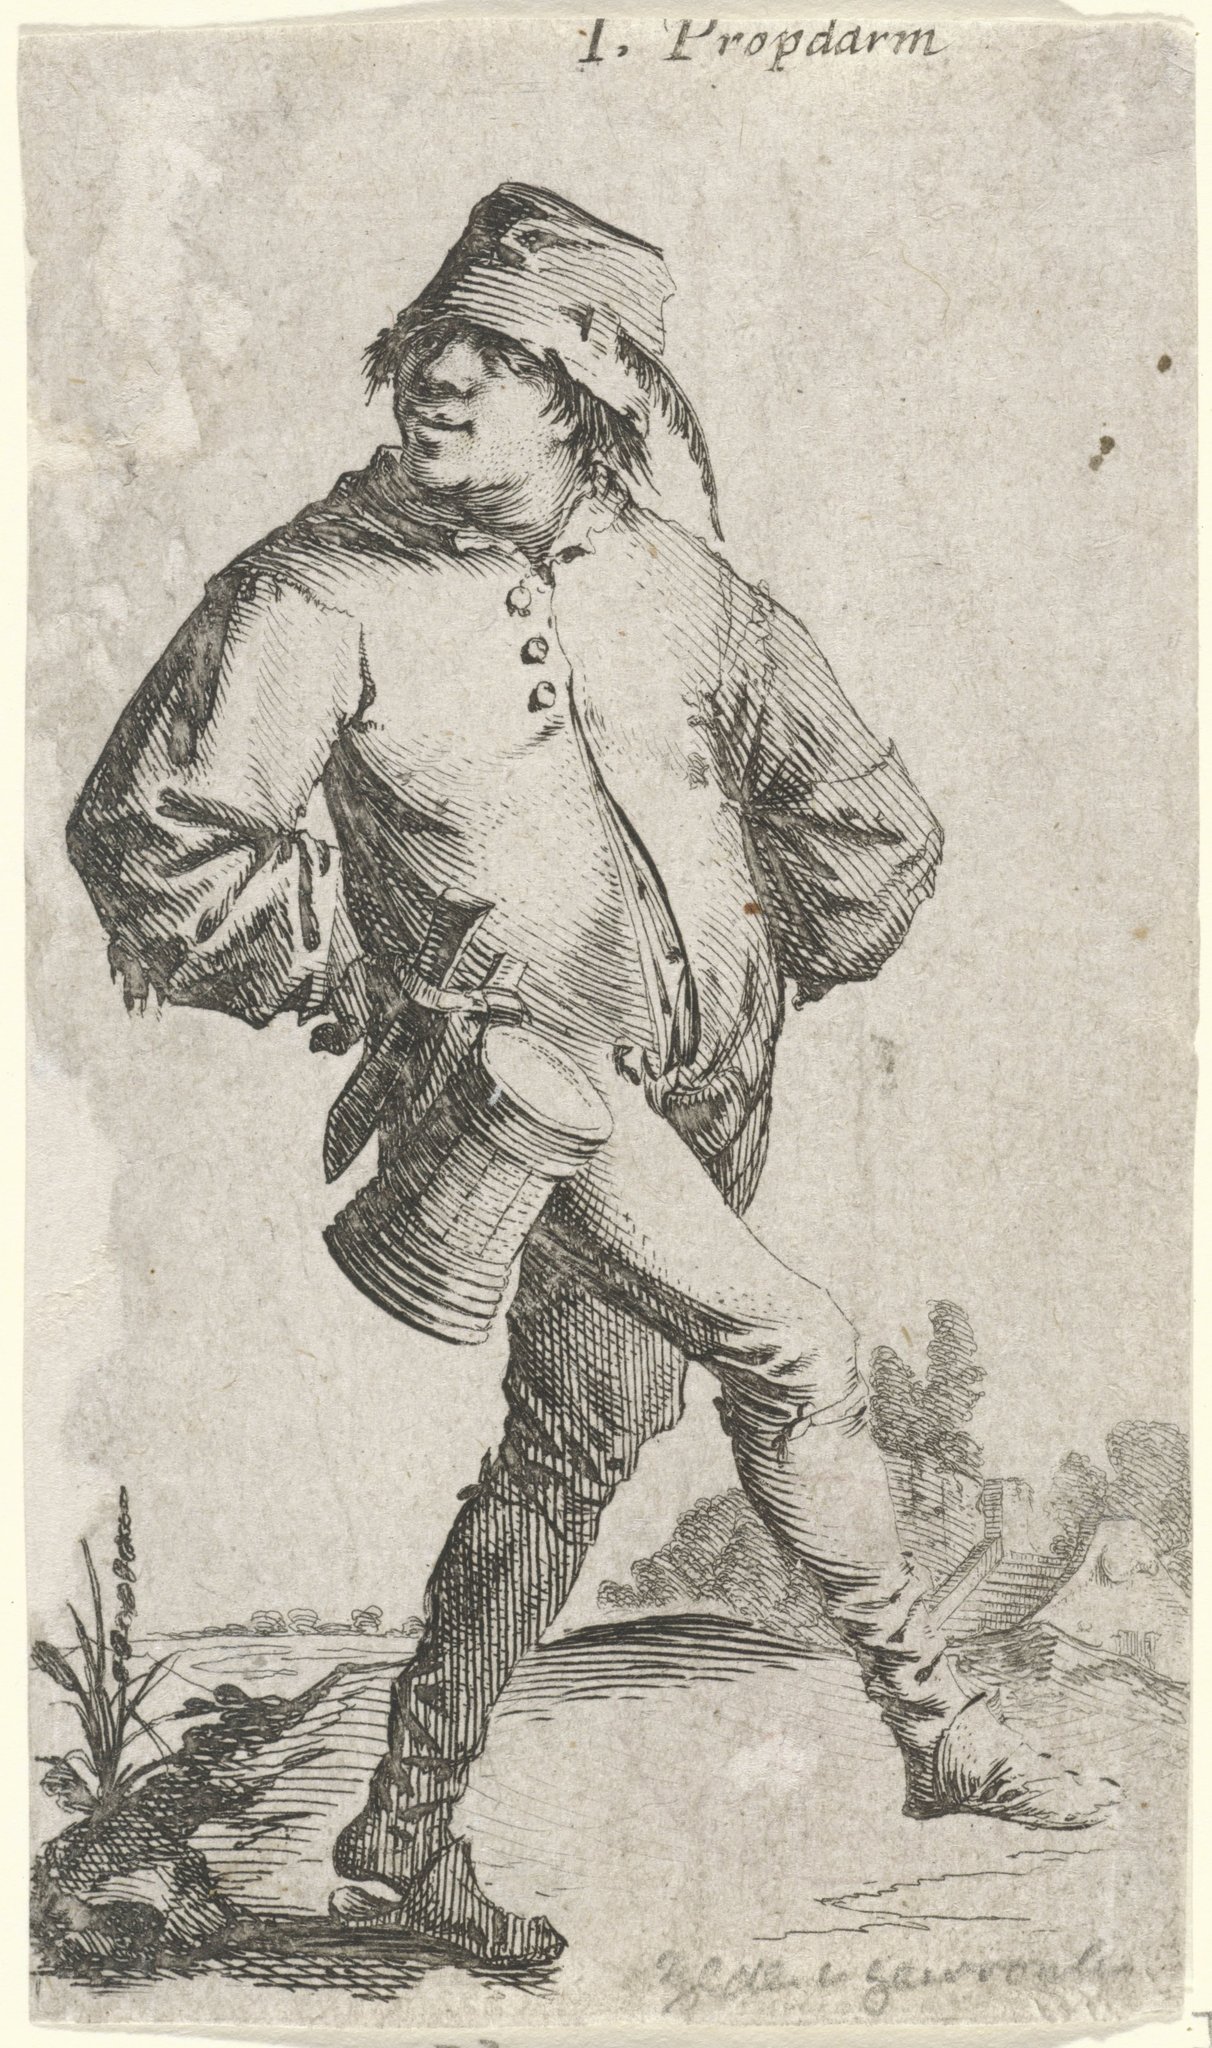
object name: print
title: I. Propdarm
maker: salomon savery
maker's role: print maker, publisher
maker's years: 1594-1683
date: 1630-1665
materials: paper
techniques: engraving, etching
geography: amsterdam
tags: hacking and thrusting weapons: dagger, farmers, drinking-vessels, man dancing alone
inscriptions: inscription: ‘Zeden en gewoonten’, collector's mark: Lugt 240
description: Zie tevens de vijf overgeleverde spiegelbeeldige kopieën naar deze serie door Reinhard Voskens.